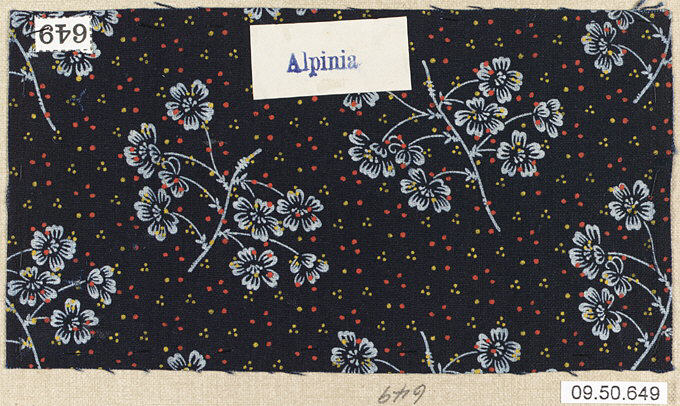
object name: piece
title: Pieces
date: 1801-1900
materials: cotton